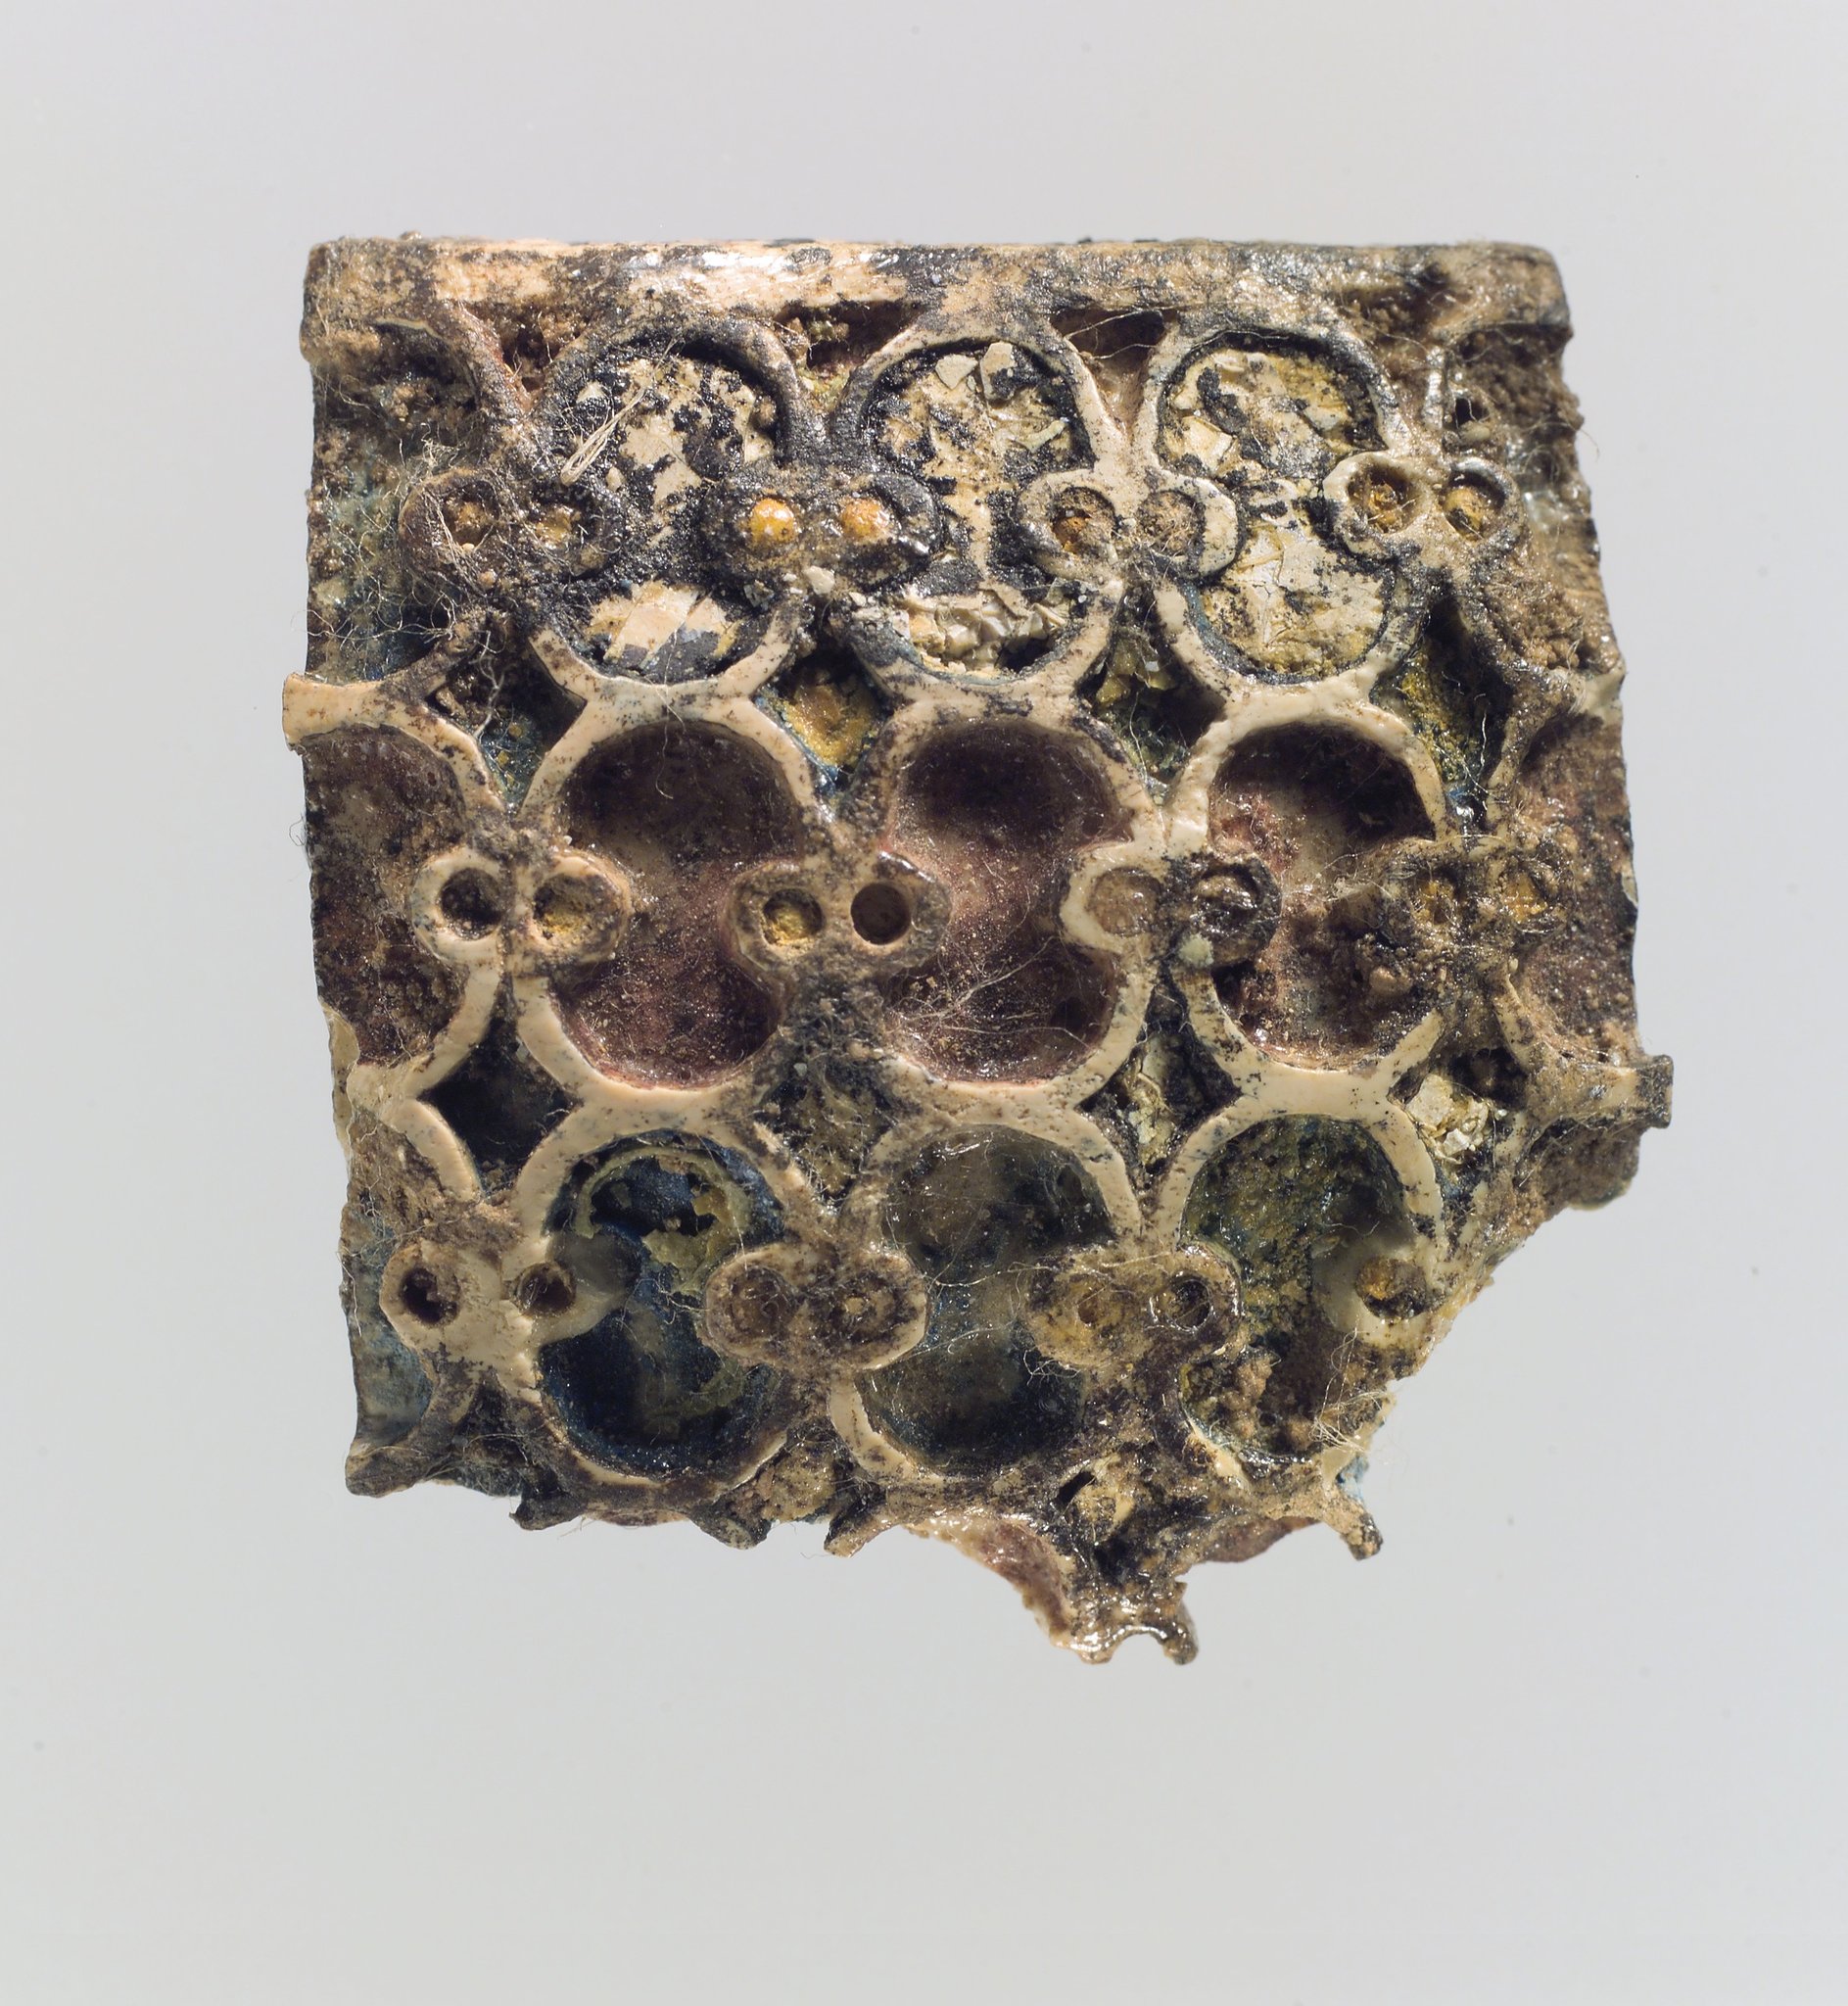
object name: relief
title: Plaque fragment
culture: assyrian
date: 800-601 BCE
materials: ivory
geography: mesopotamia